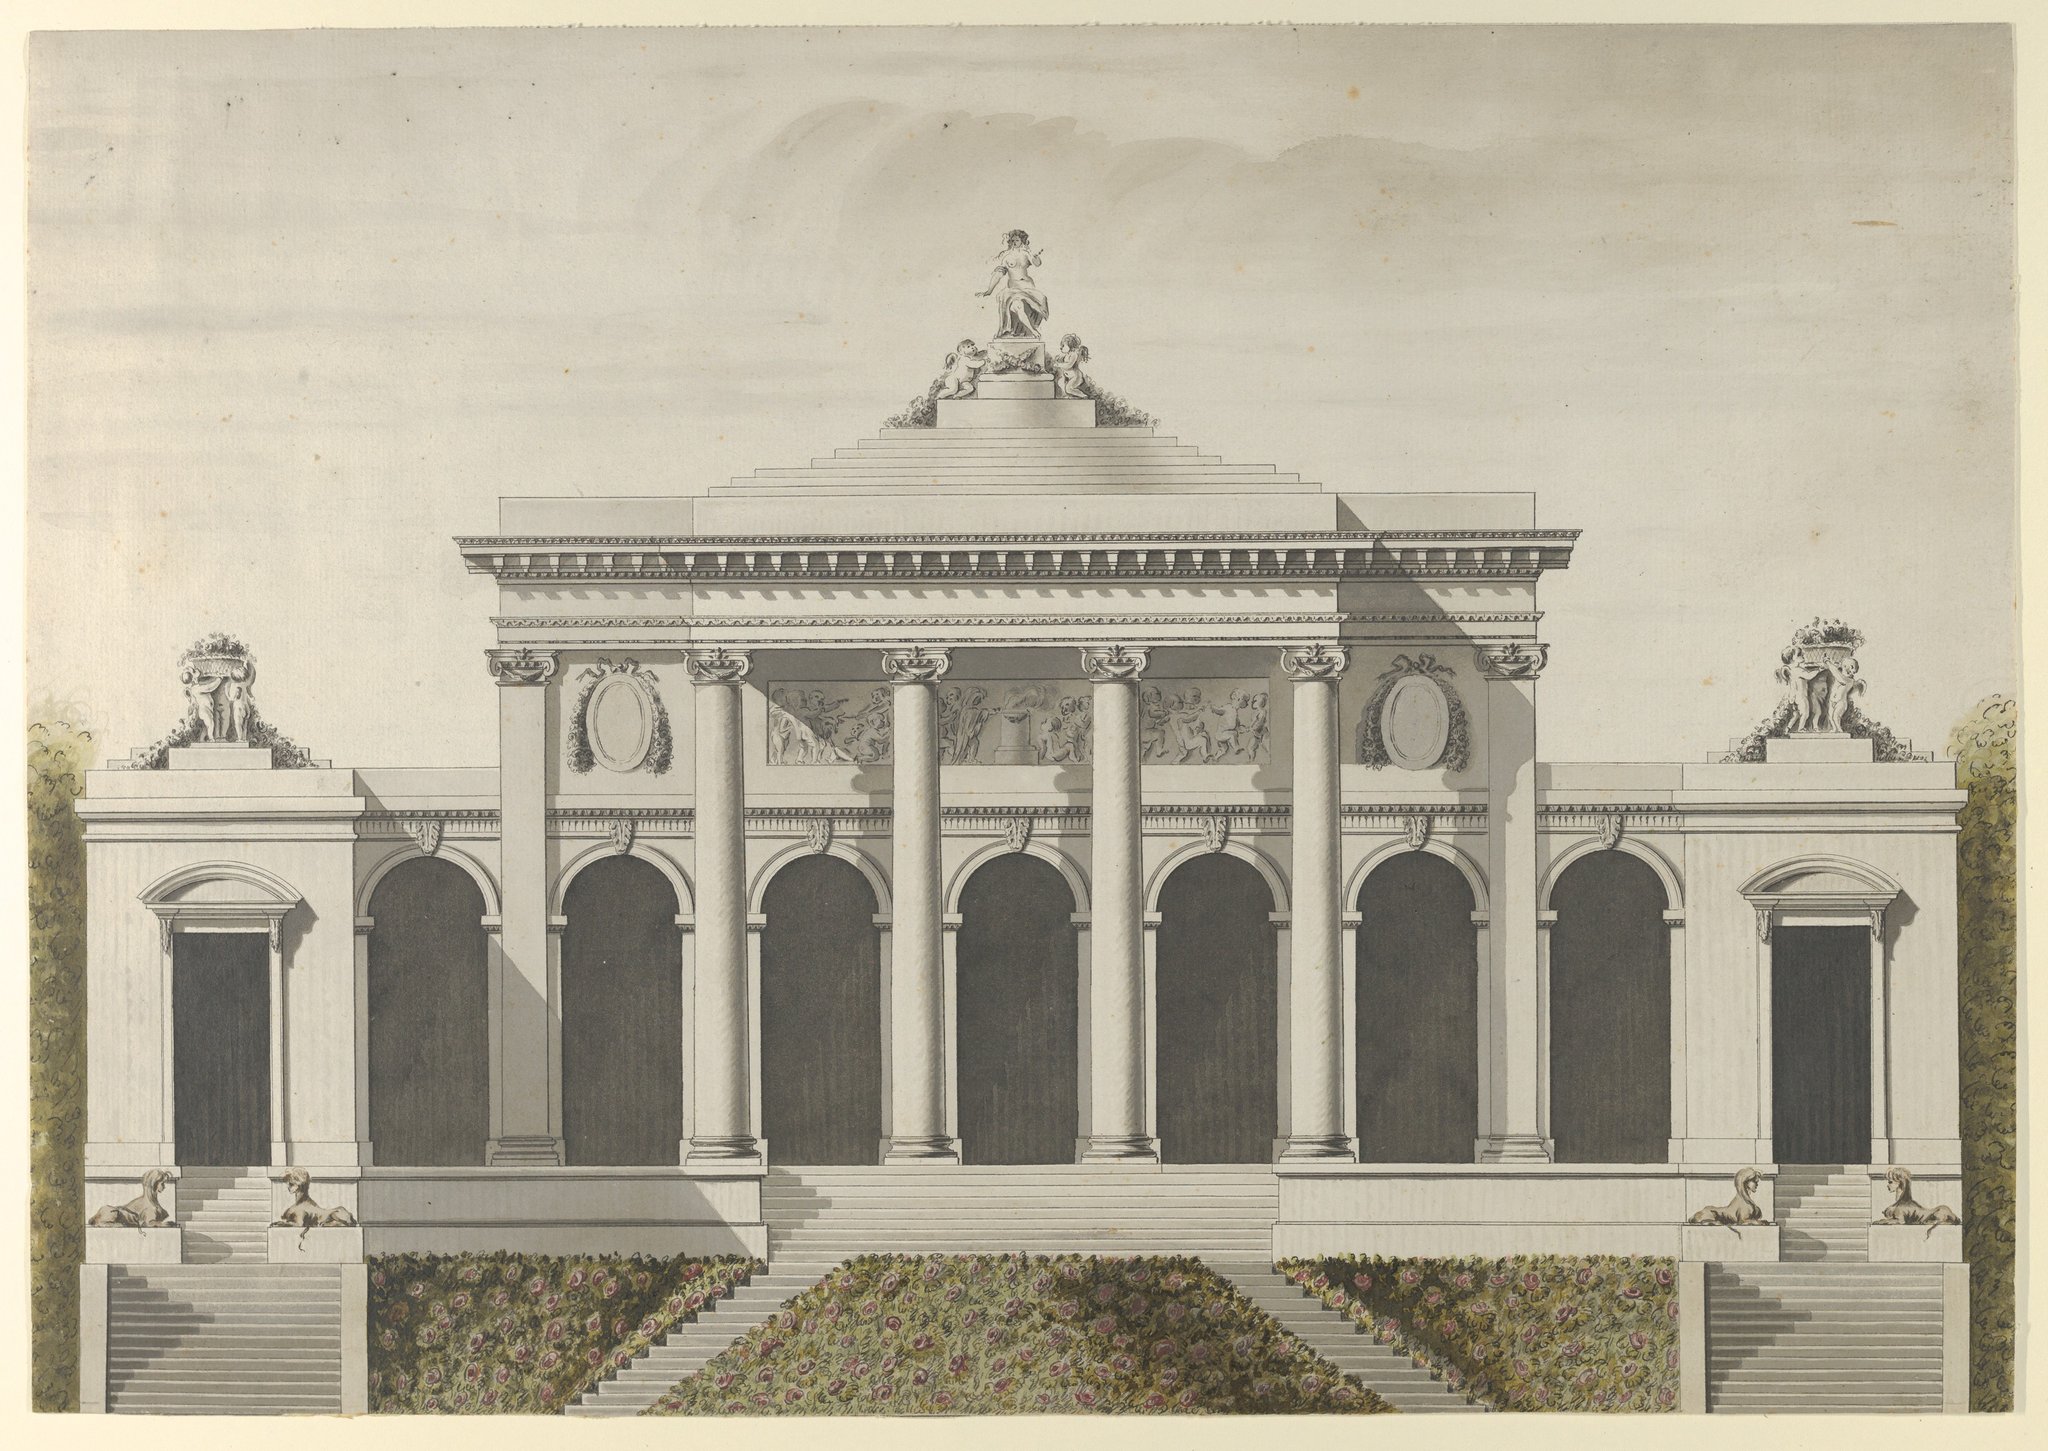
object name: drawing collection ornament architecture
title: Elevation for the Garden-Front of the Hotel de Brunoy, Faubourg St. Honoré, Paris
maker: etienne louis boullée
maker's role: artist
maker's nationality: french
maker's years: 1728-1799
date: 1779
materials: ink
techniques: brush, pen, wash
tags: architecture,buildings